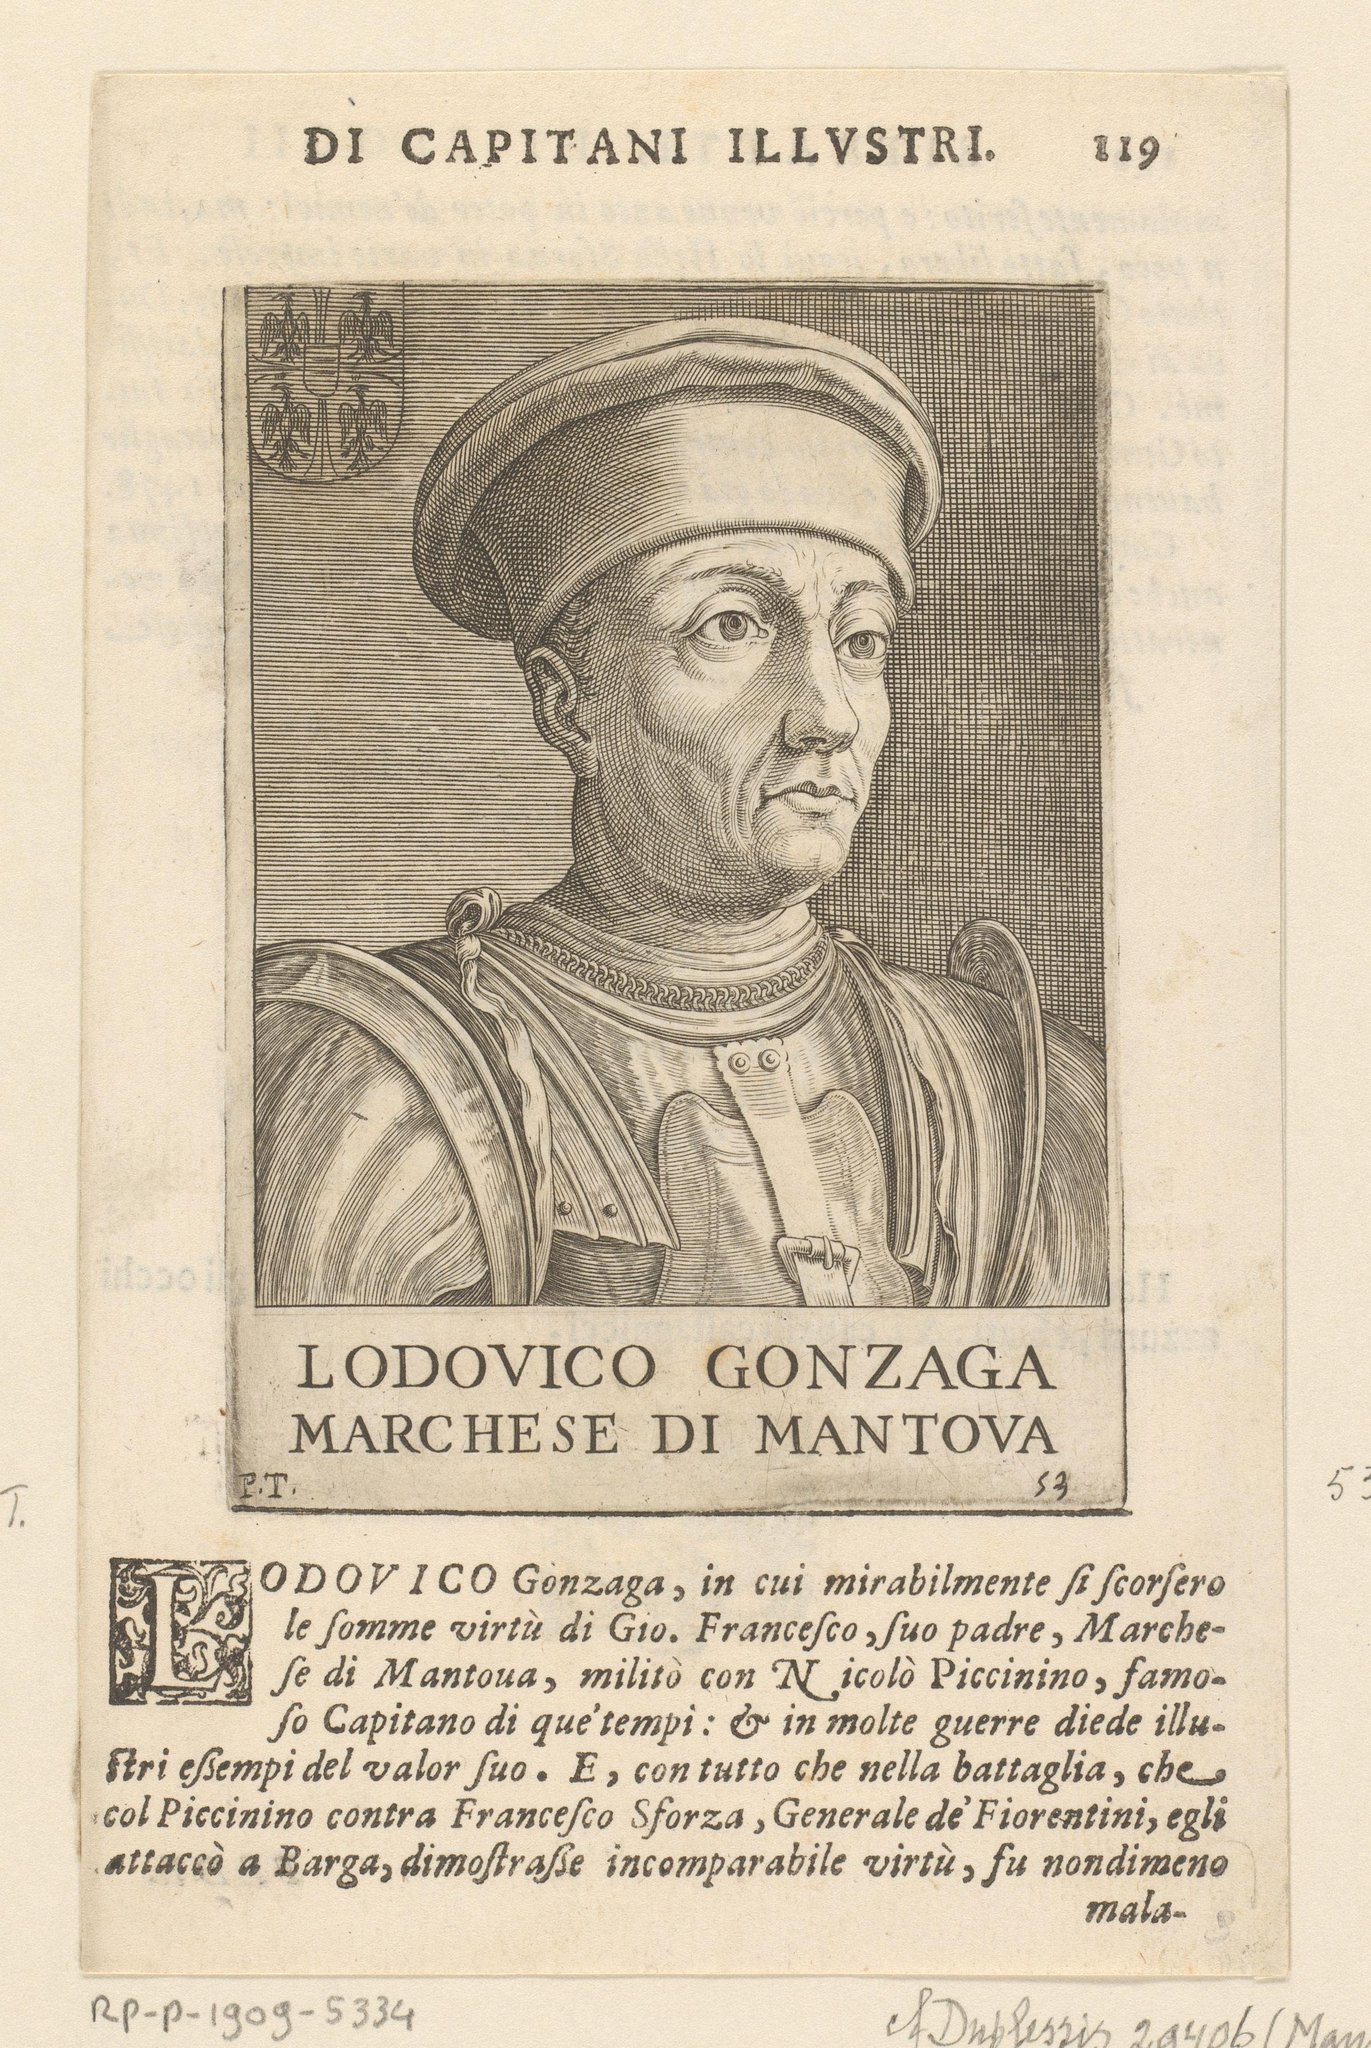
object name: print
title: Portret van Ludovico Gonzaga III, markies van Mantua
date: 1635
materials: paper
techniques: engraving, letterpress printing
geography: rome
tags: ludovico iii gonzaga (markies van mantua), historical persons, armorial bearing, heraldry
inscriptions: collector's mark: Lugt 2228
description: Prent uit: Ritratti et elogii di capitani Illustri. Rome: Pompilio Totti en Andrea Fei, 1635, p. 10. Eerdere staat van prent in ieder geval ook gebruikt in: Ritratti di cento capitani illustri con li lor Fatti in guerra (…), Rome: Domenico Gigliotti, 1596. Latere staat van prent in ieder geval ook gebruikt in: Ritratti et elogii di capitani Illustri. Che ne'secoli moderni hanno gloriosamente guerreggiato. Rome: Filippo de'Rossi en Vitale Mascardi, 1646.